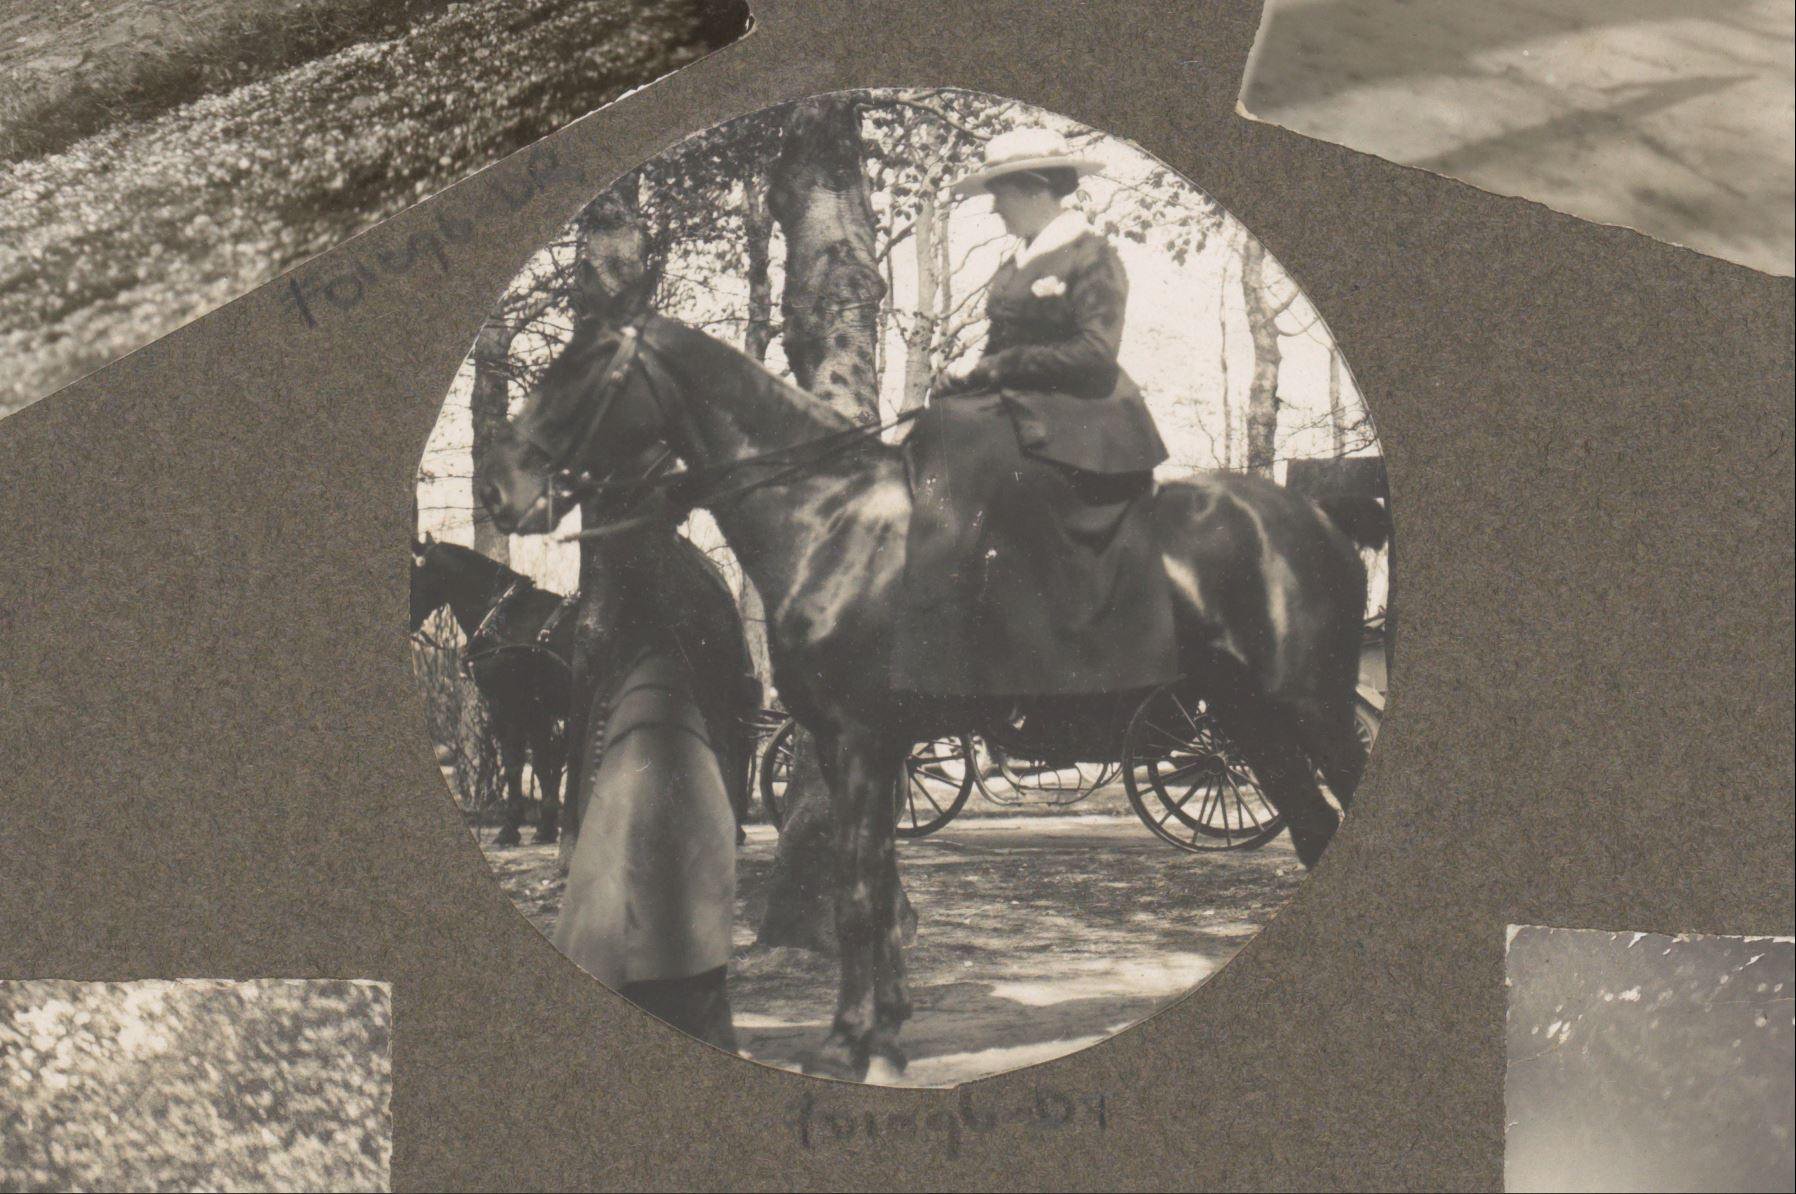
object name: photograph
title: Ruitertafereel op Koninklijke Houtvesterij Het Loo: vrouw te paard in amazonezit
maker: Anonymous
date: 1900-1925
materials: photographic support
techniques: gelatin silver print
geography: het loo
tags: riding a horse, ass, or mule; rider, horseman, hunting, chase, hunting-ground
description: Onderdeel van Fotoalbum van de heer Brams, opperhoutvester van koningin Wilhelmina op Koninklijke Houtvesterij Het Loo.